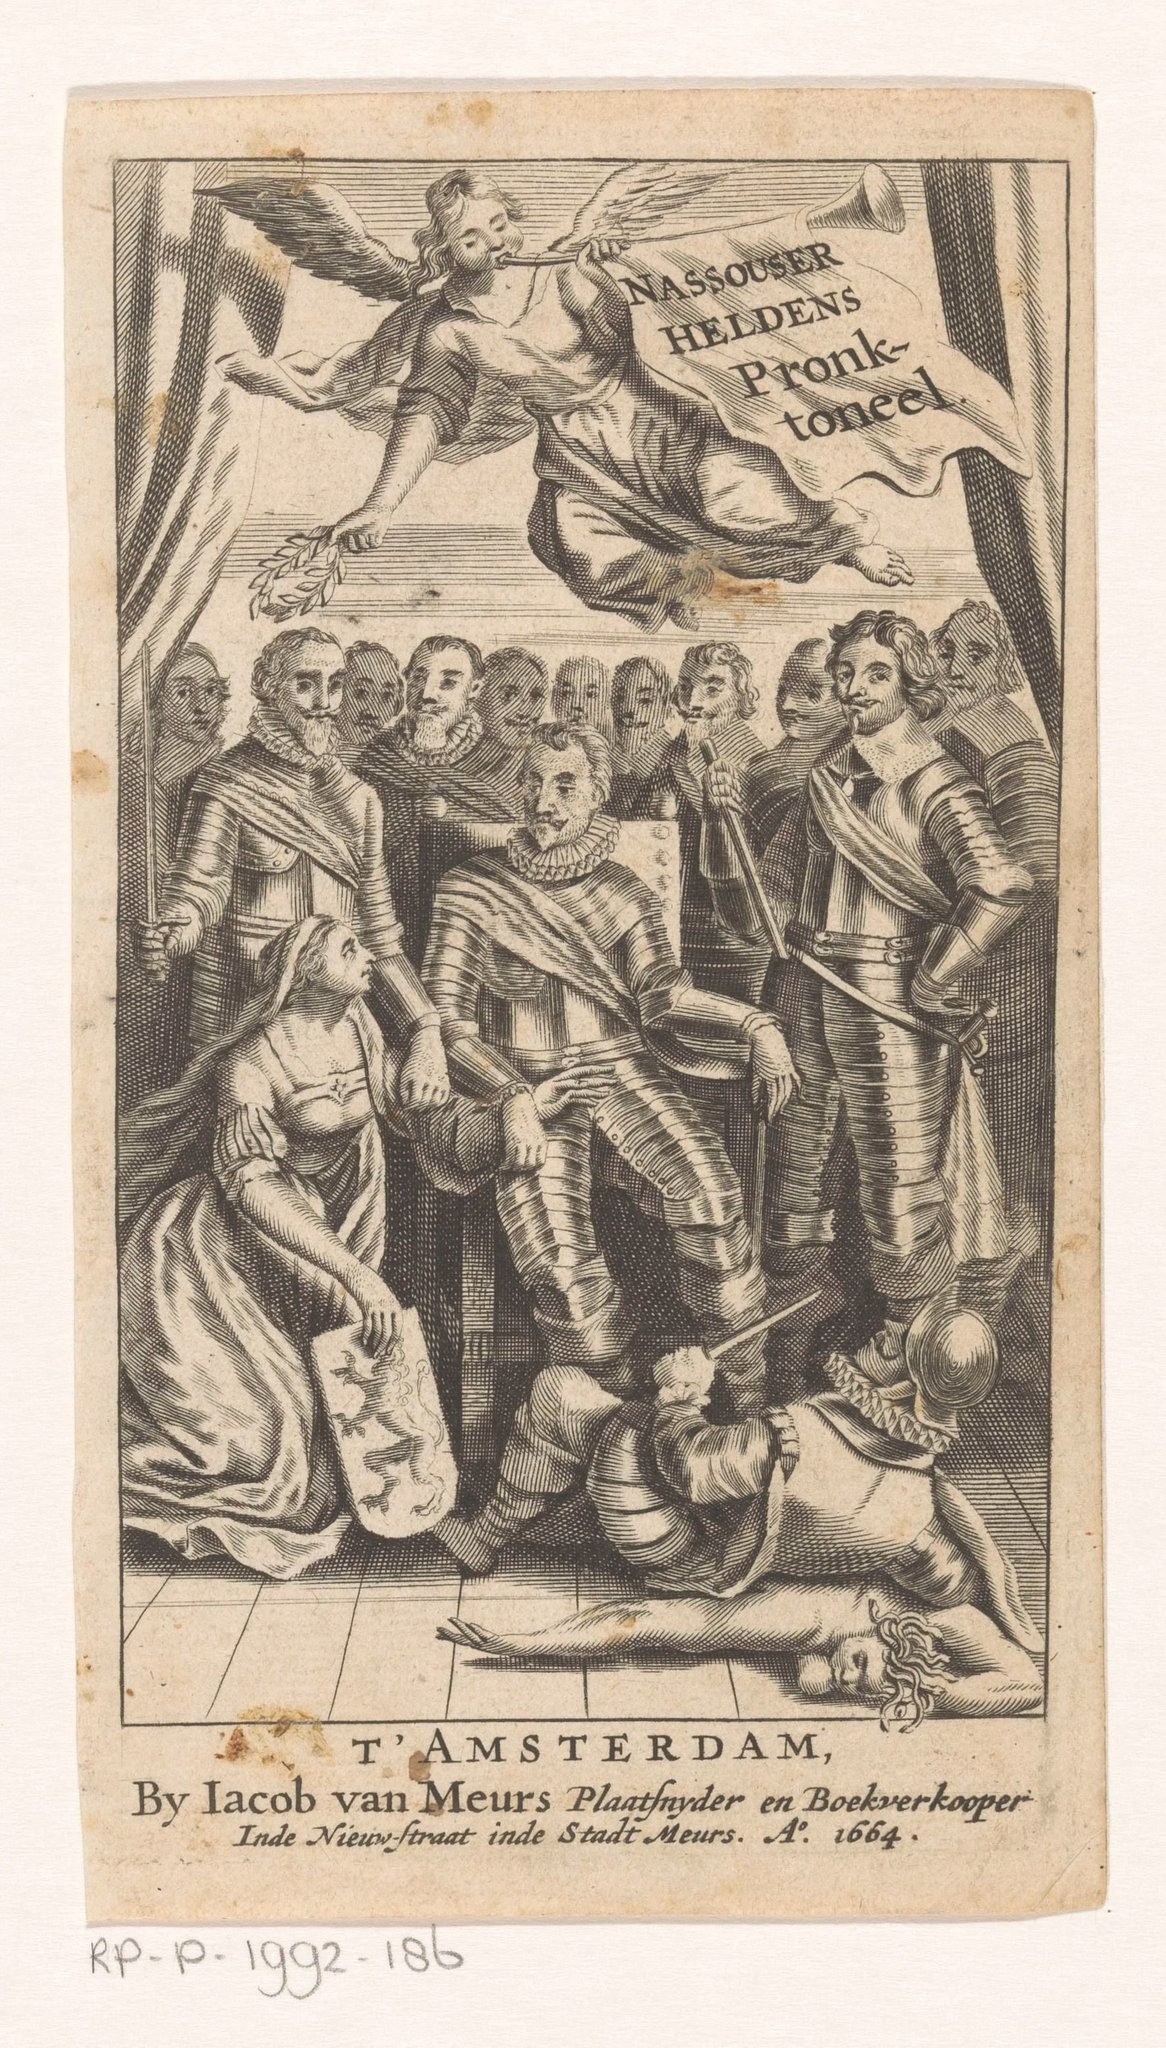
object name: titelblad, titelpagina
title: Titelpagina voor: S.n., Nassouser heldens pronk-toonneel opgetooydt, en volcierdt met de keurlĳkste helden van Nassou en Oranje, 1664.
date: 1664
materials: paper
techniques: engraving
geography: amsterdam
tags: personifications of countries, nations, states, districts, etc., prince, ruler, sovereign, fame; 'fama', 'fama buona', 'fama chiara' (ripa)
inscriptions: collector's mark: Lugt 2228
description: Een groep geharnaste mannen (mogelijk prinsen van Oranje en/of stadhouders) staat rondom een zittende man. Voor hem ligt een soldaat op zijn rug op een Medusa-figuur. Links zit de Hollandse Maagd met wapenschild. Aan de bovenzijde vliegt Faam met bazuin en lauwerkrans.